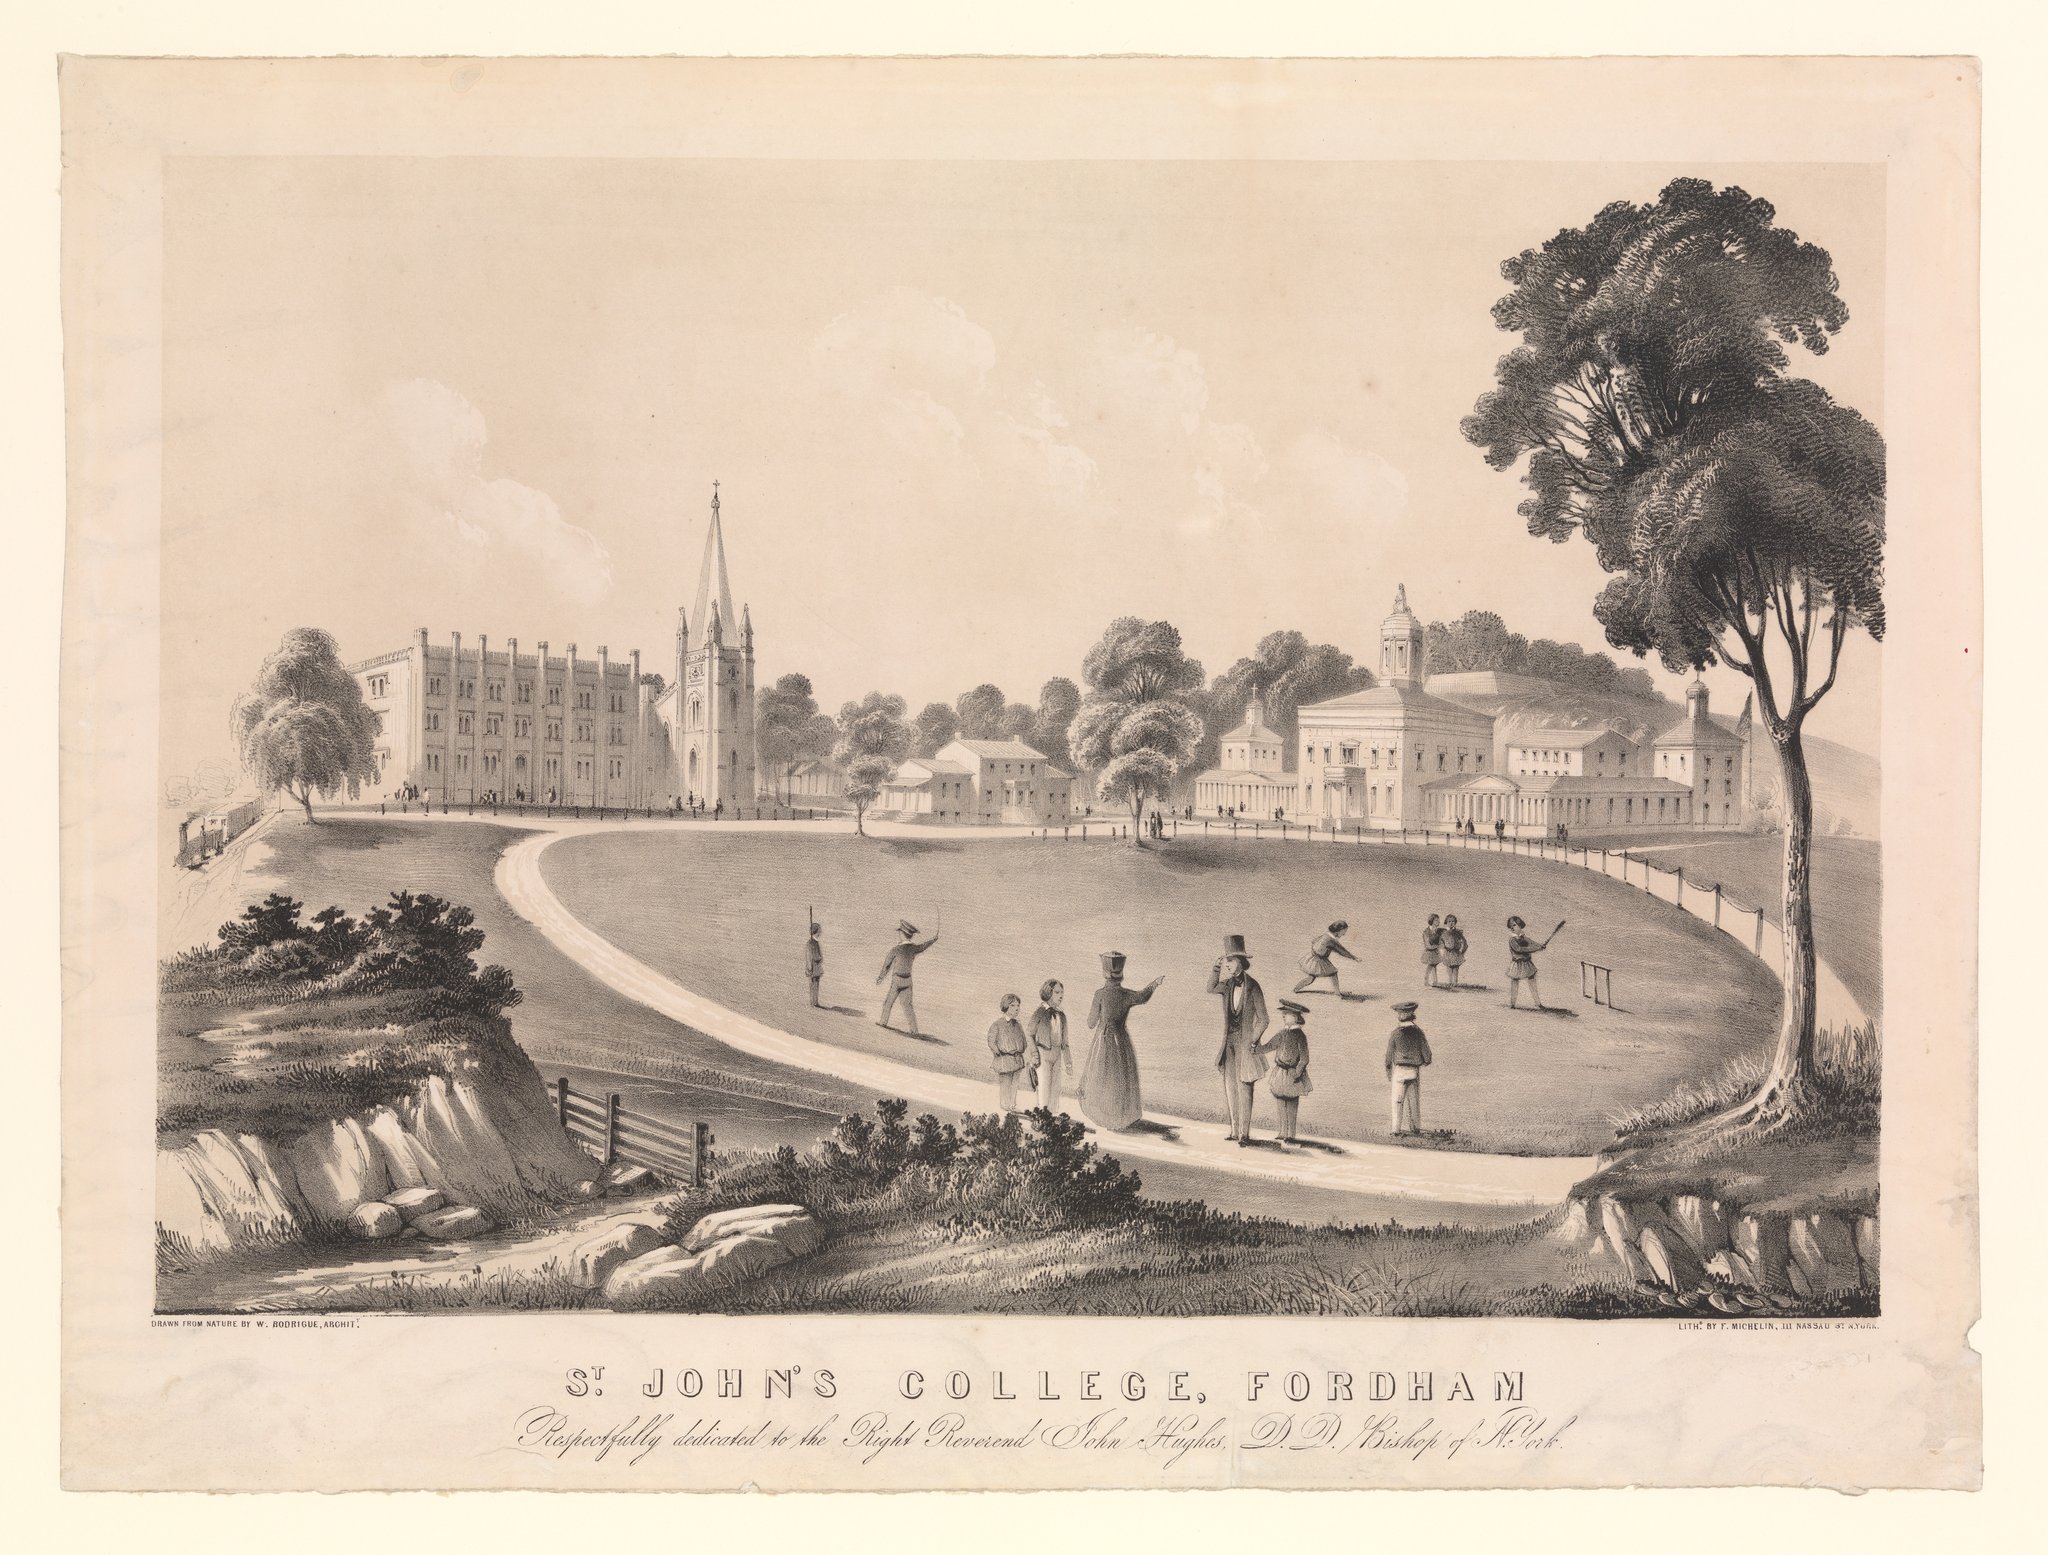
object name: print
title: St. John's College Fordham, New York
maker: william rodrigue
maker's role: artist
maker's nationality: american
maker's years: 1800-1867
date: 1846-1851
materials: stone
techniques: lithograph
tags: buildings,men,women,playing,trees